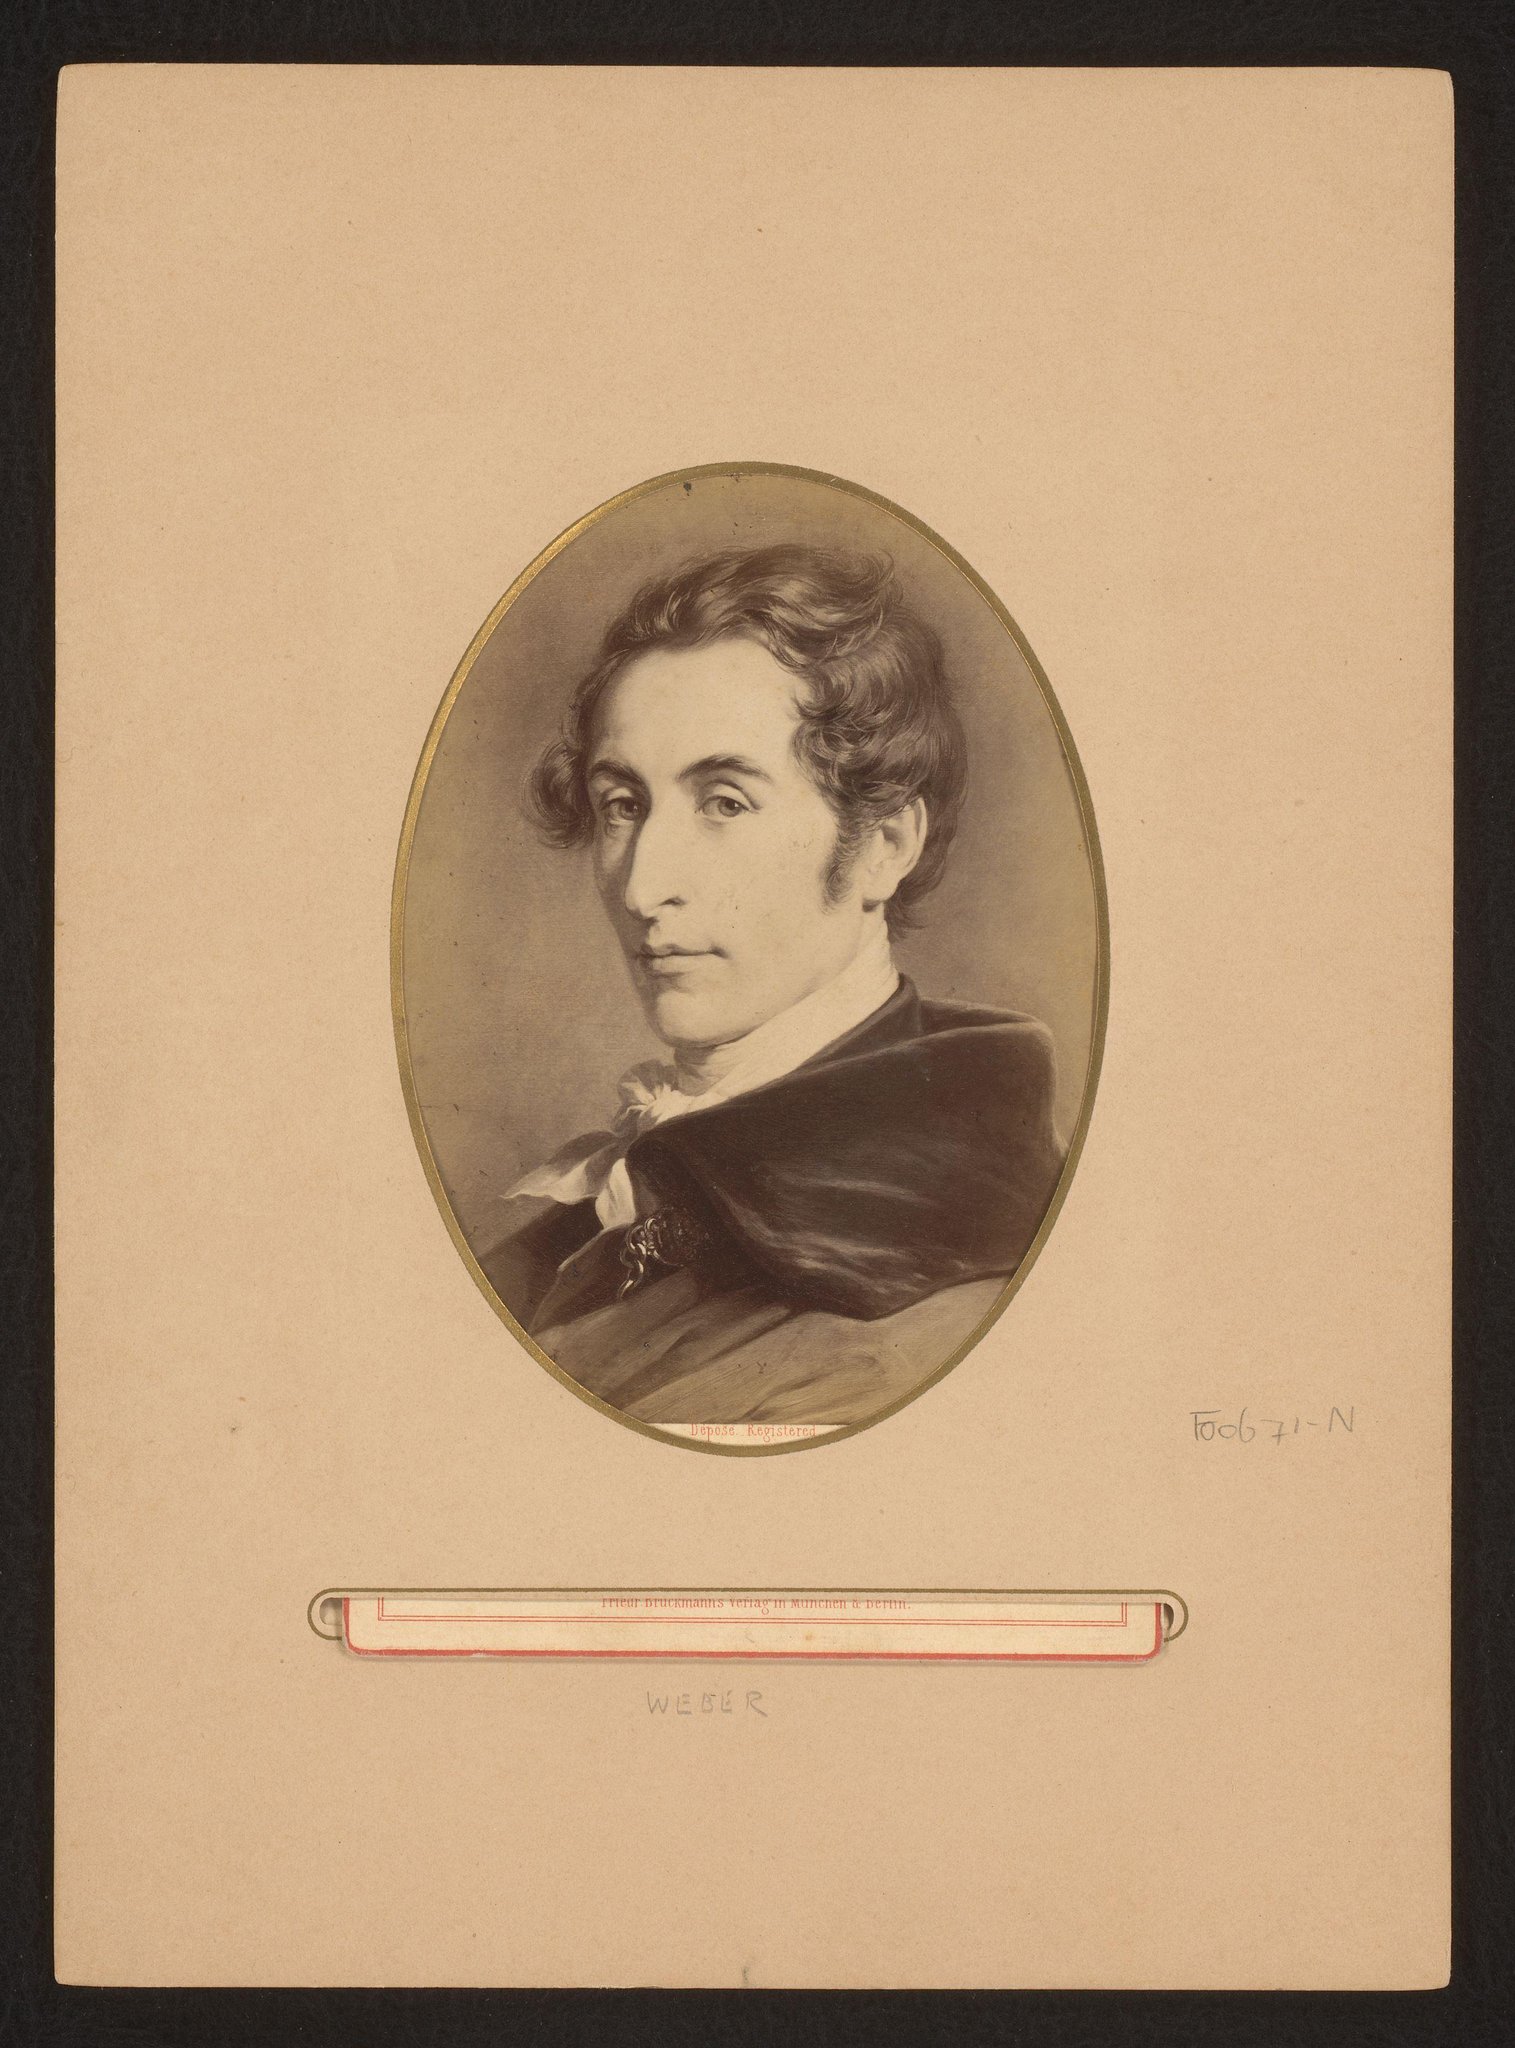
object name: cabinet photograph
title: Fotoreproductie van een geschilderd portret van Carl Maria von Weber door Carl Jaeger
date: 1870-1900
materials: cardboard, photographic support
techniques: albumen print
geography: germany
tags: carl maria von weber, historical persons, portrait of composer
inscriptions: name: ‘Weber’, inscription: ‘C. Jäger pinx./ Dépose. Registerd/ Fr. Bruckmann phot./ Weber/ Friedr. Bruckmann's Verlag in München & Berlin’